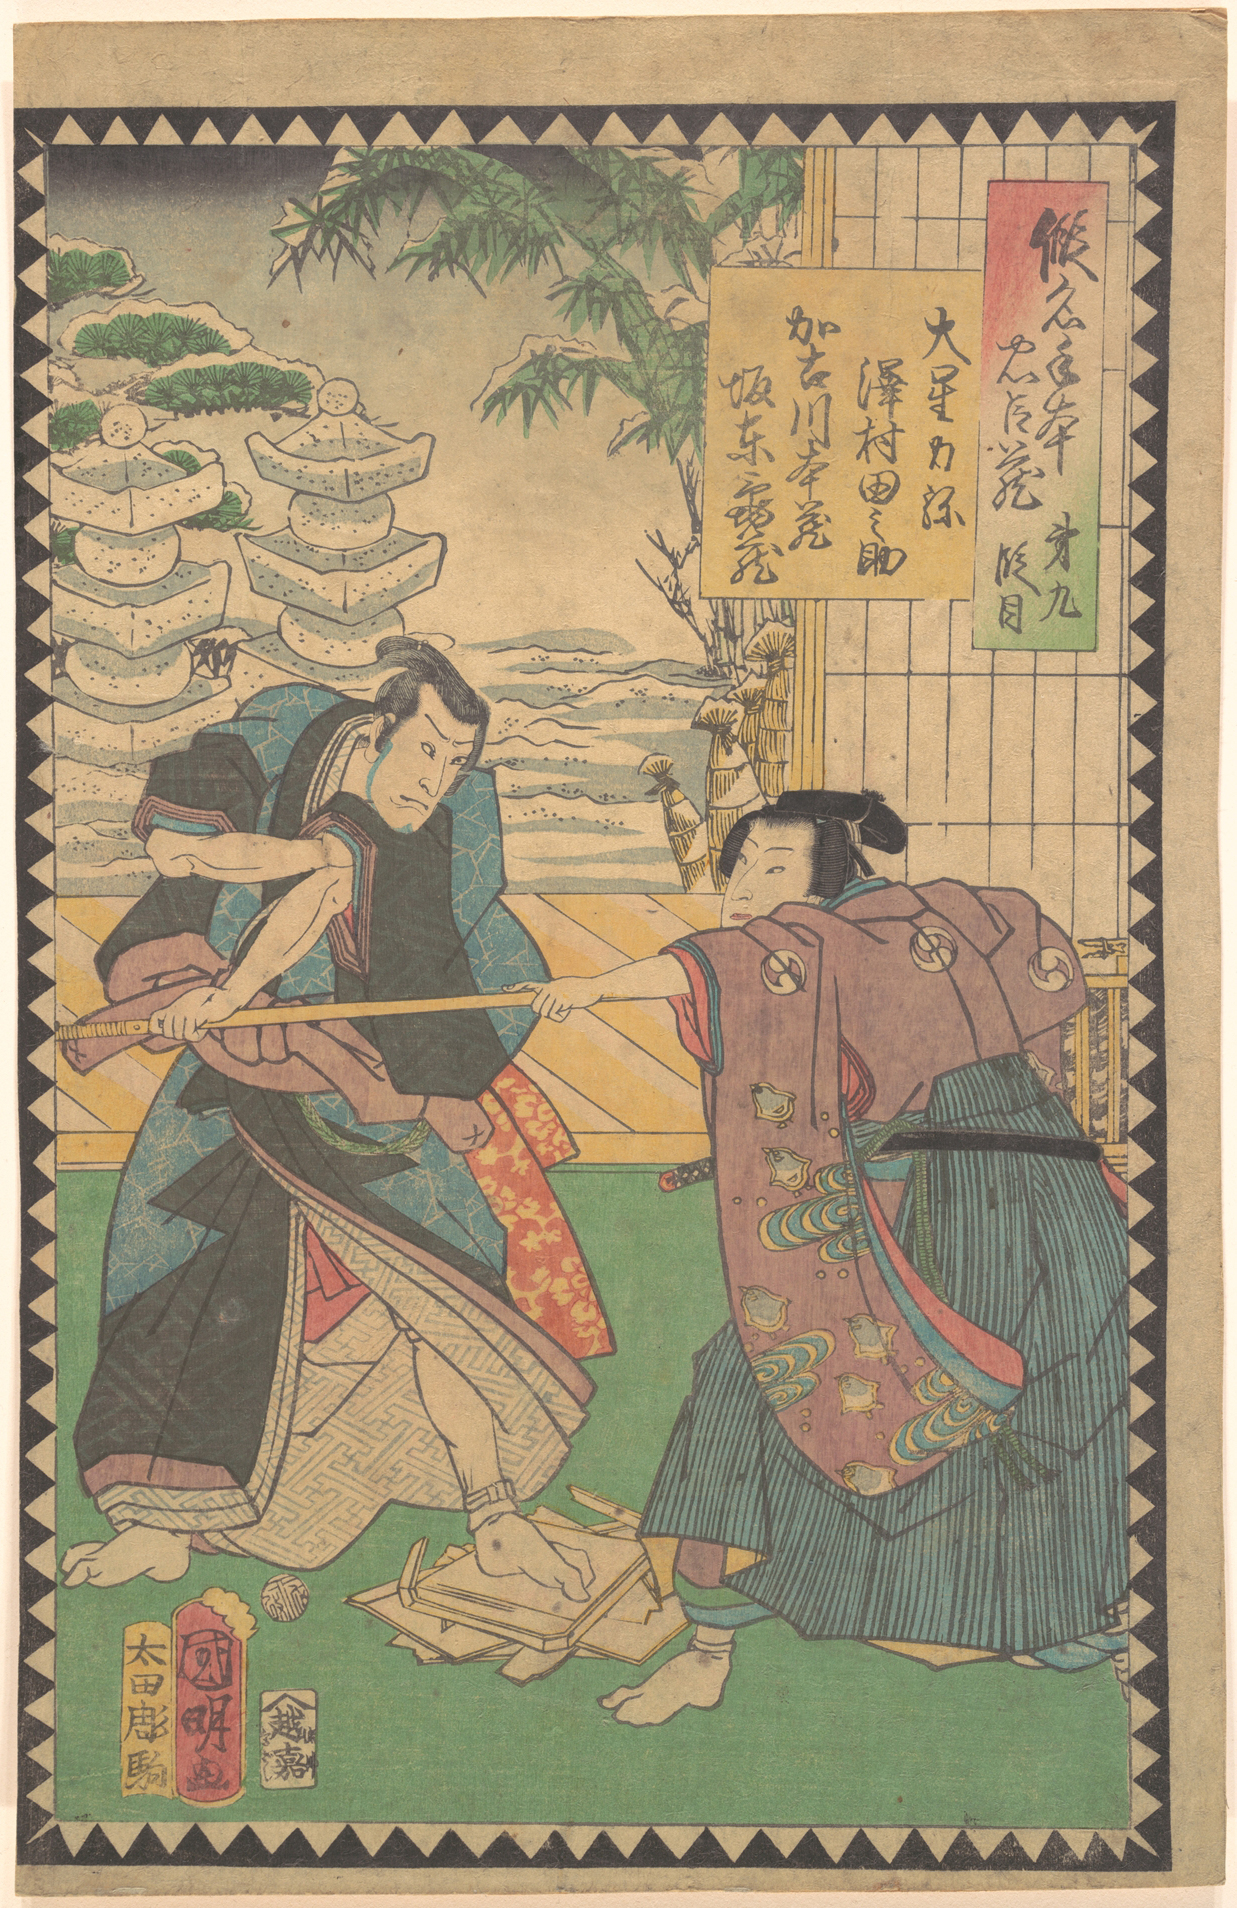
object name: print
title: Act IX (Dai kudanme): Actors Sawamura Tanosuke III as Ōboshi Rikiya and Bandō Kamezō I as Kakogawa Honzō, from the series The Storehouse of Loyal Retainers, a Primer (Kanadehon chūshingura)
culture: japanese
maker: utagawa kuniaki ii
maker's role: artist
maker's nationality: japanese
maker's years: 1835-1888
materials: ink, paper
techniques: woodblock print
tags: men,actors